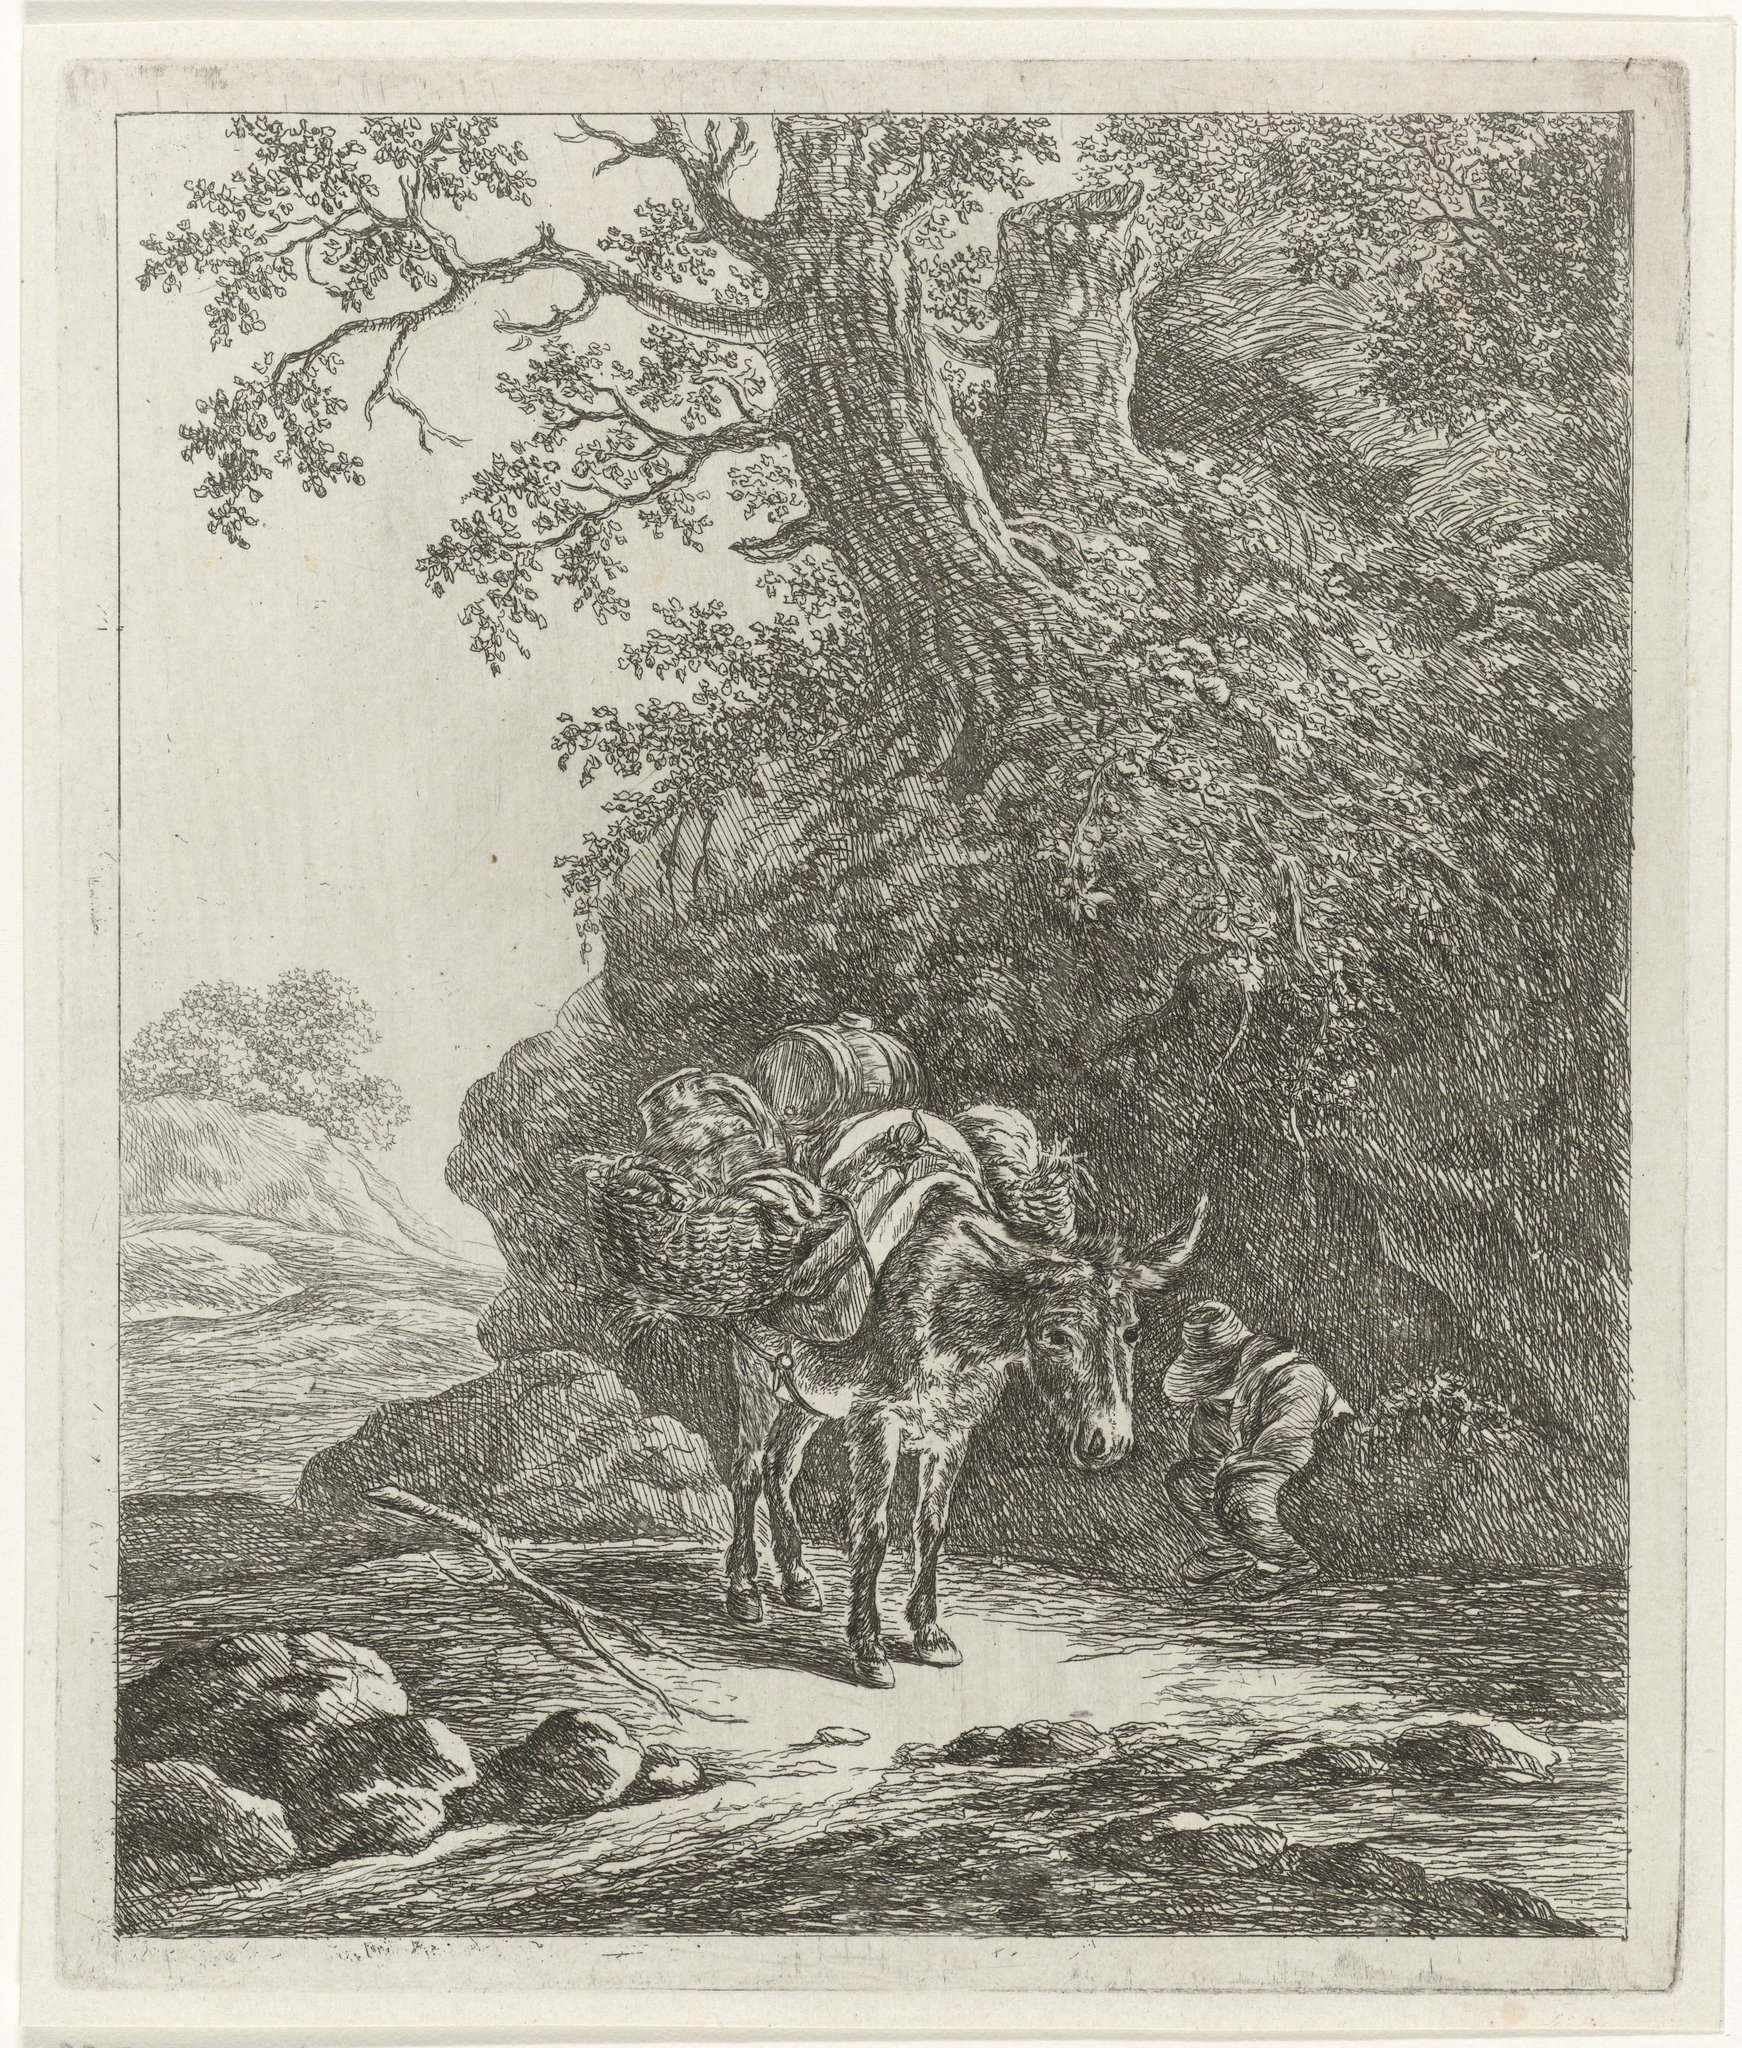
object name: print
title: Pakezel op landweg met zich ontlastende man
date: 1752-1783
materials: paper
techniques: etching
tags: pack-animal, ass, donkey, defecation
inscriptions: collector's mark: Lugt 2228